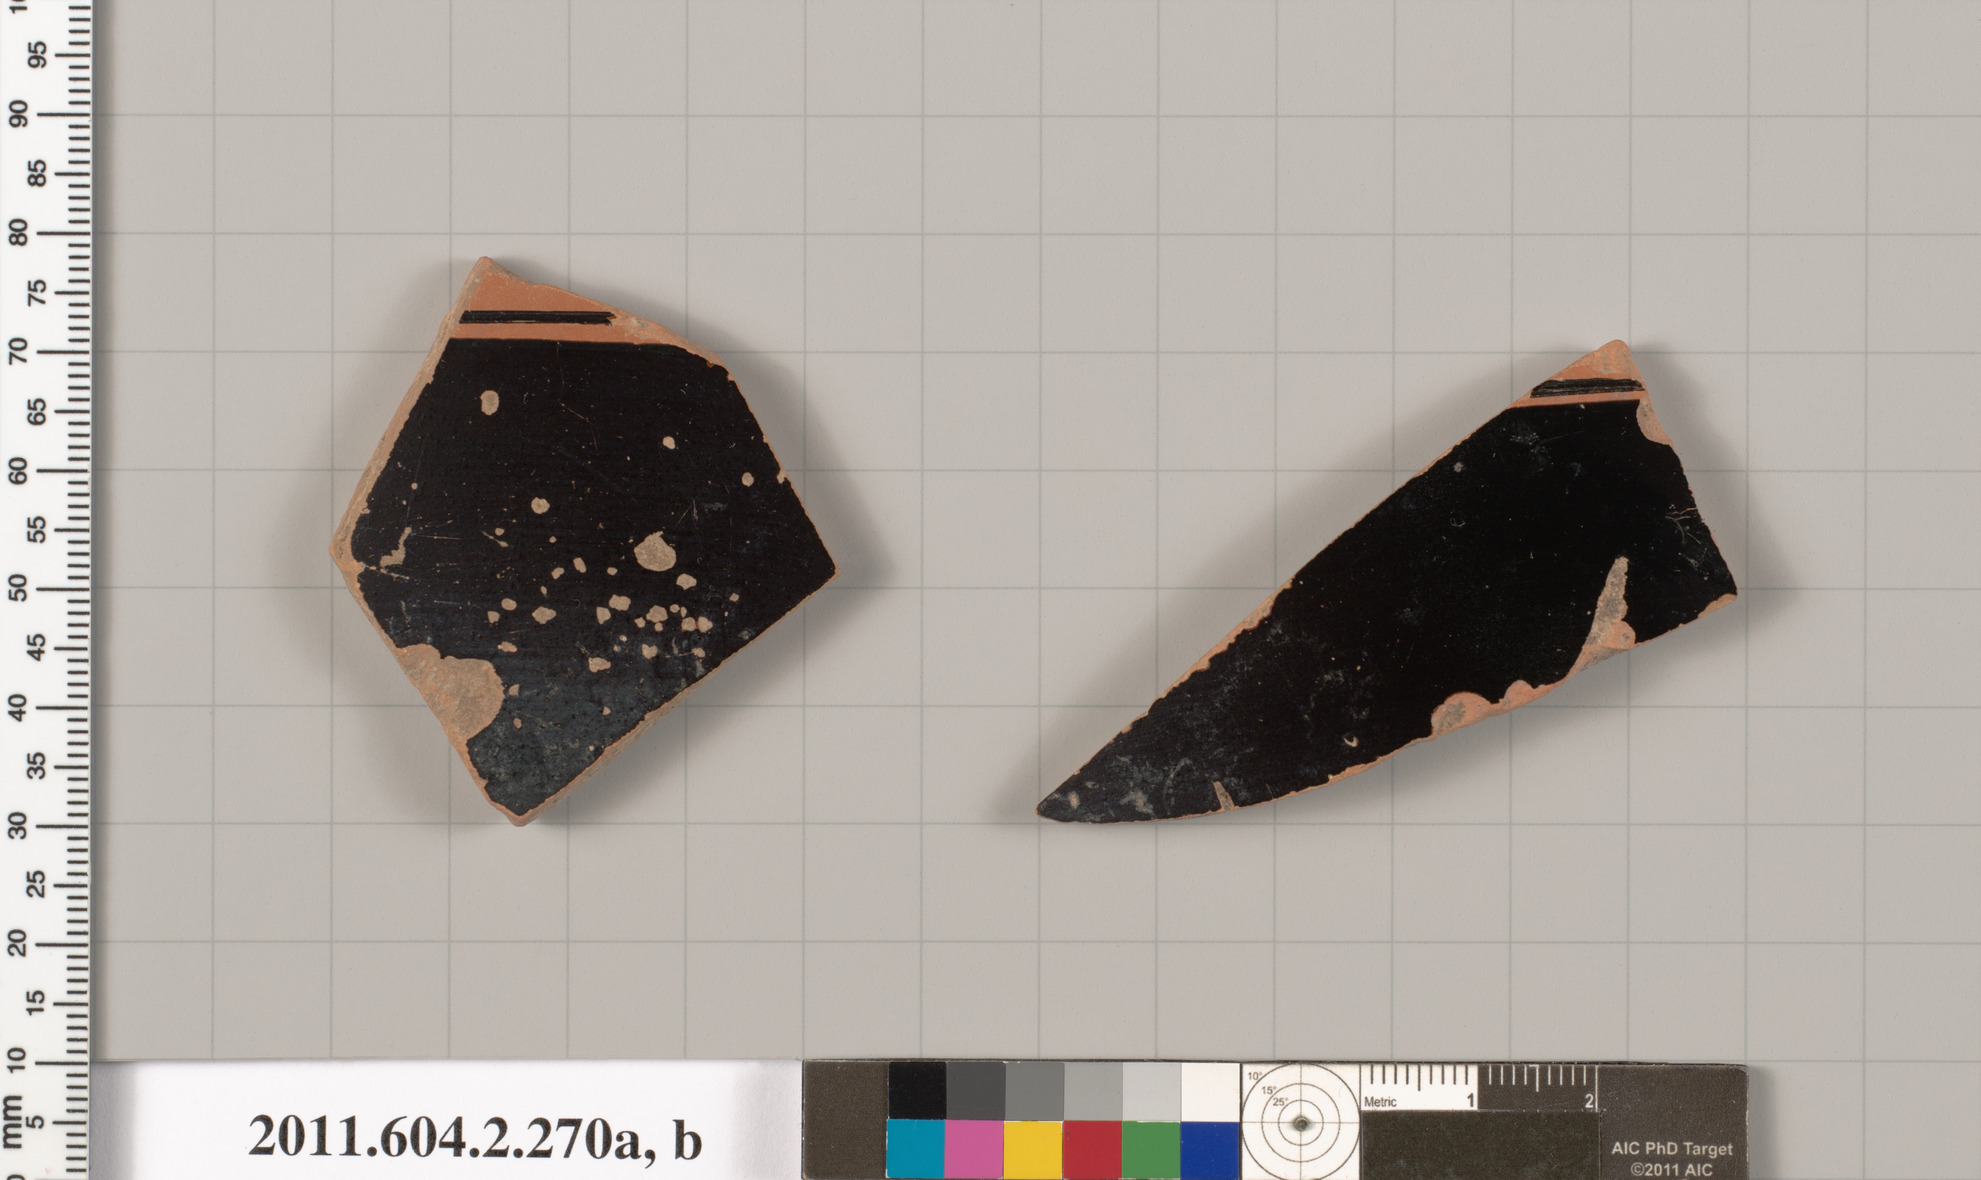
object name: stamnoi fragment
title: Terracotta fragments of stamnoi (jars)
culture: greek, attic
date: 490-470 BCE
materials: terracotta